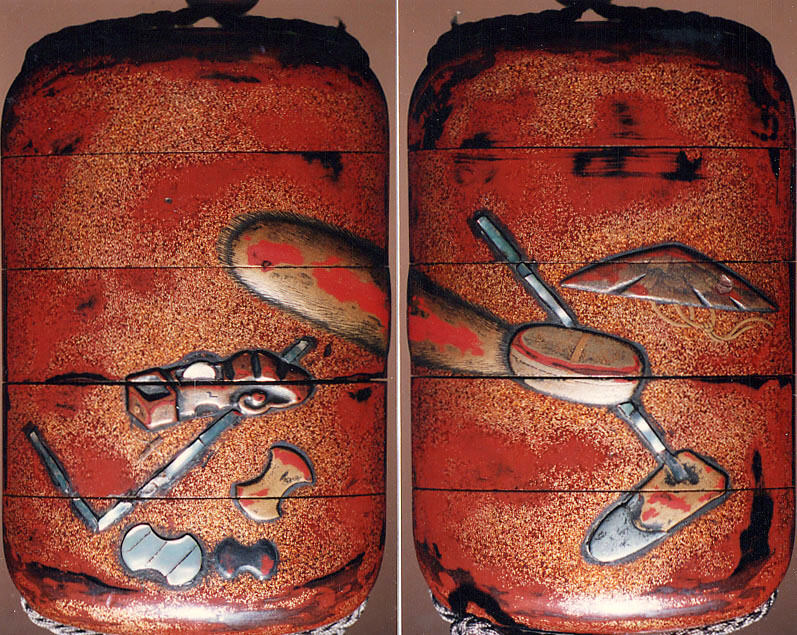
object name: inrō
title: Case (Inrō) with Design of Tools of Various Trades (Carpenter, Farmer, Merchant)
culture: japanese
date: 1801-1833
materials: gold, lacquer, silver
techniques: fundame, hiramakie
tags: tools